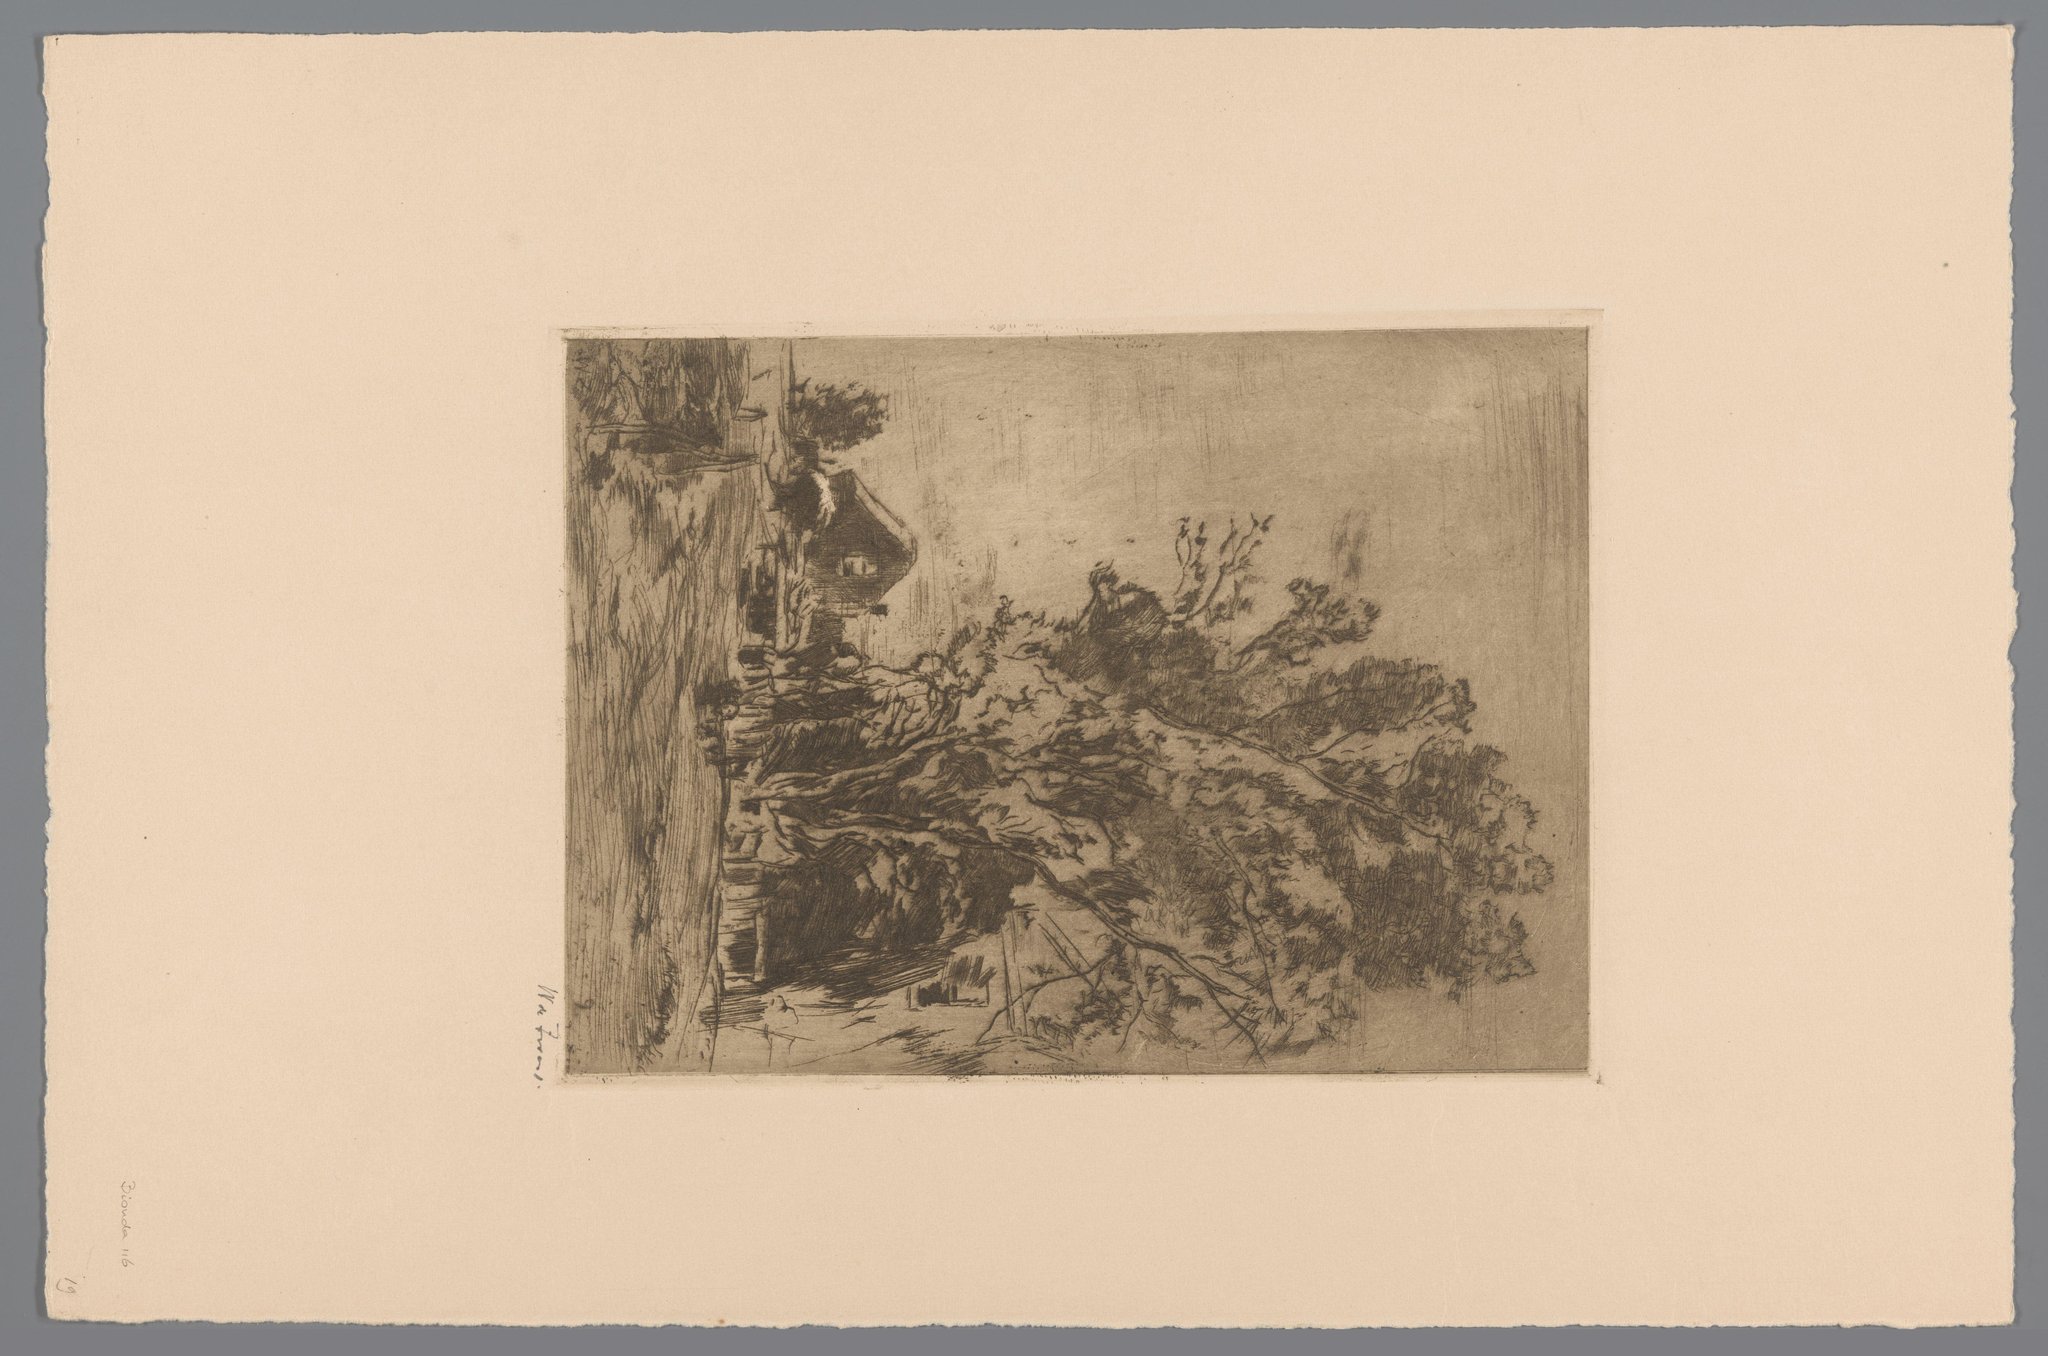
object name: print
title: Landweg met huizen en bomen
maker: willem de zwart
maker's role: draughtsman, painter, print maker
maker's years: 1862-1931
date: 1924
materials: paper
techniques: etching, intaglio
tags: road, path, farm or solitary house in landscape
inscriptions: collector's mark: Lugt 2760, collector's mark: Lugt 2228